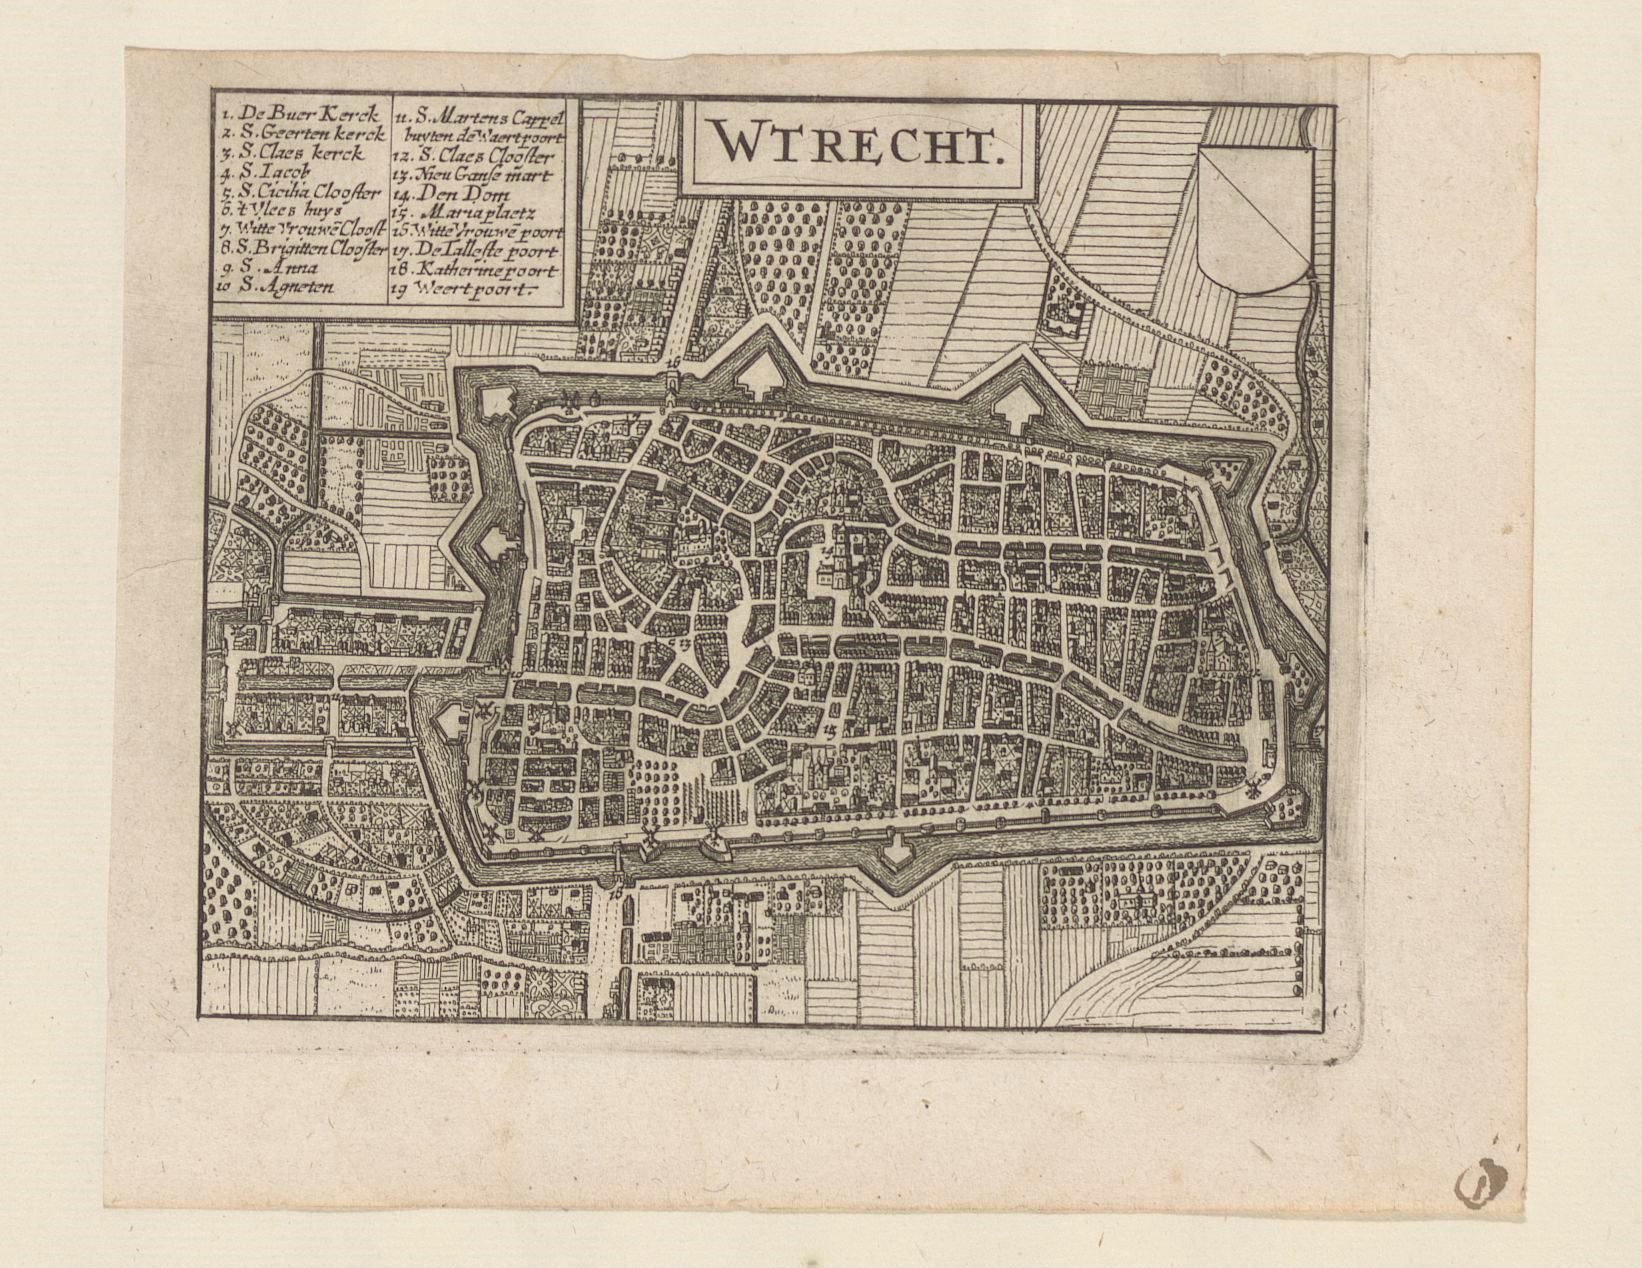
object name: area plan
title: Wtrecht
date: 1652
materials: paper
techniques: engraving, etching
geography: amsterdam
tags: coat of arms (as symbol of the state, etc.), maps of cities, utrecht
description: Prent ook gebruikt in: Guicciardini, Lodovico. Belgicae, sive inferioris Germaniae descriptio. 3 delen. Amsterdam: Johannes Janssonius, 1652, dl. 3, tussen p. 192 en 193.